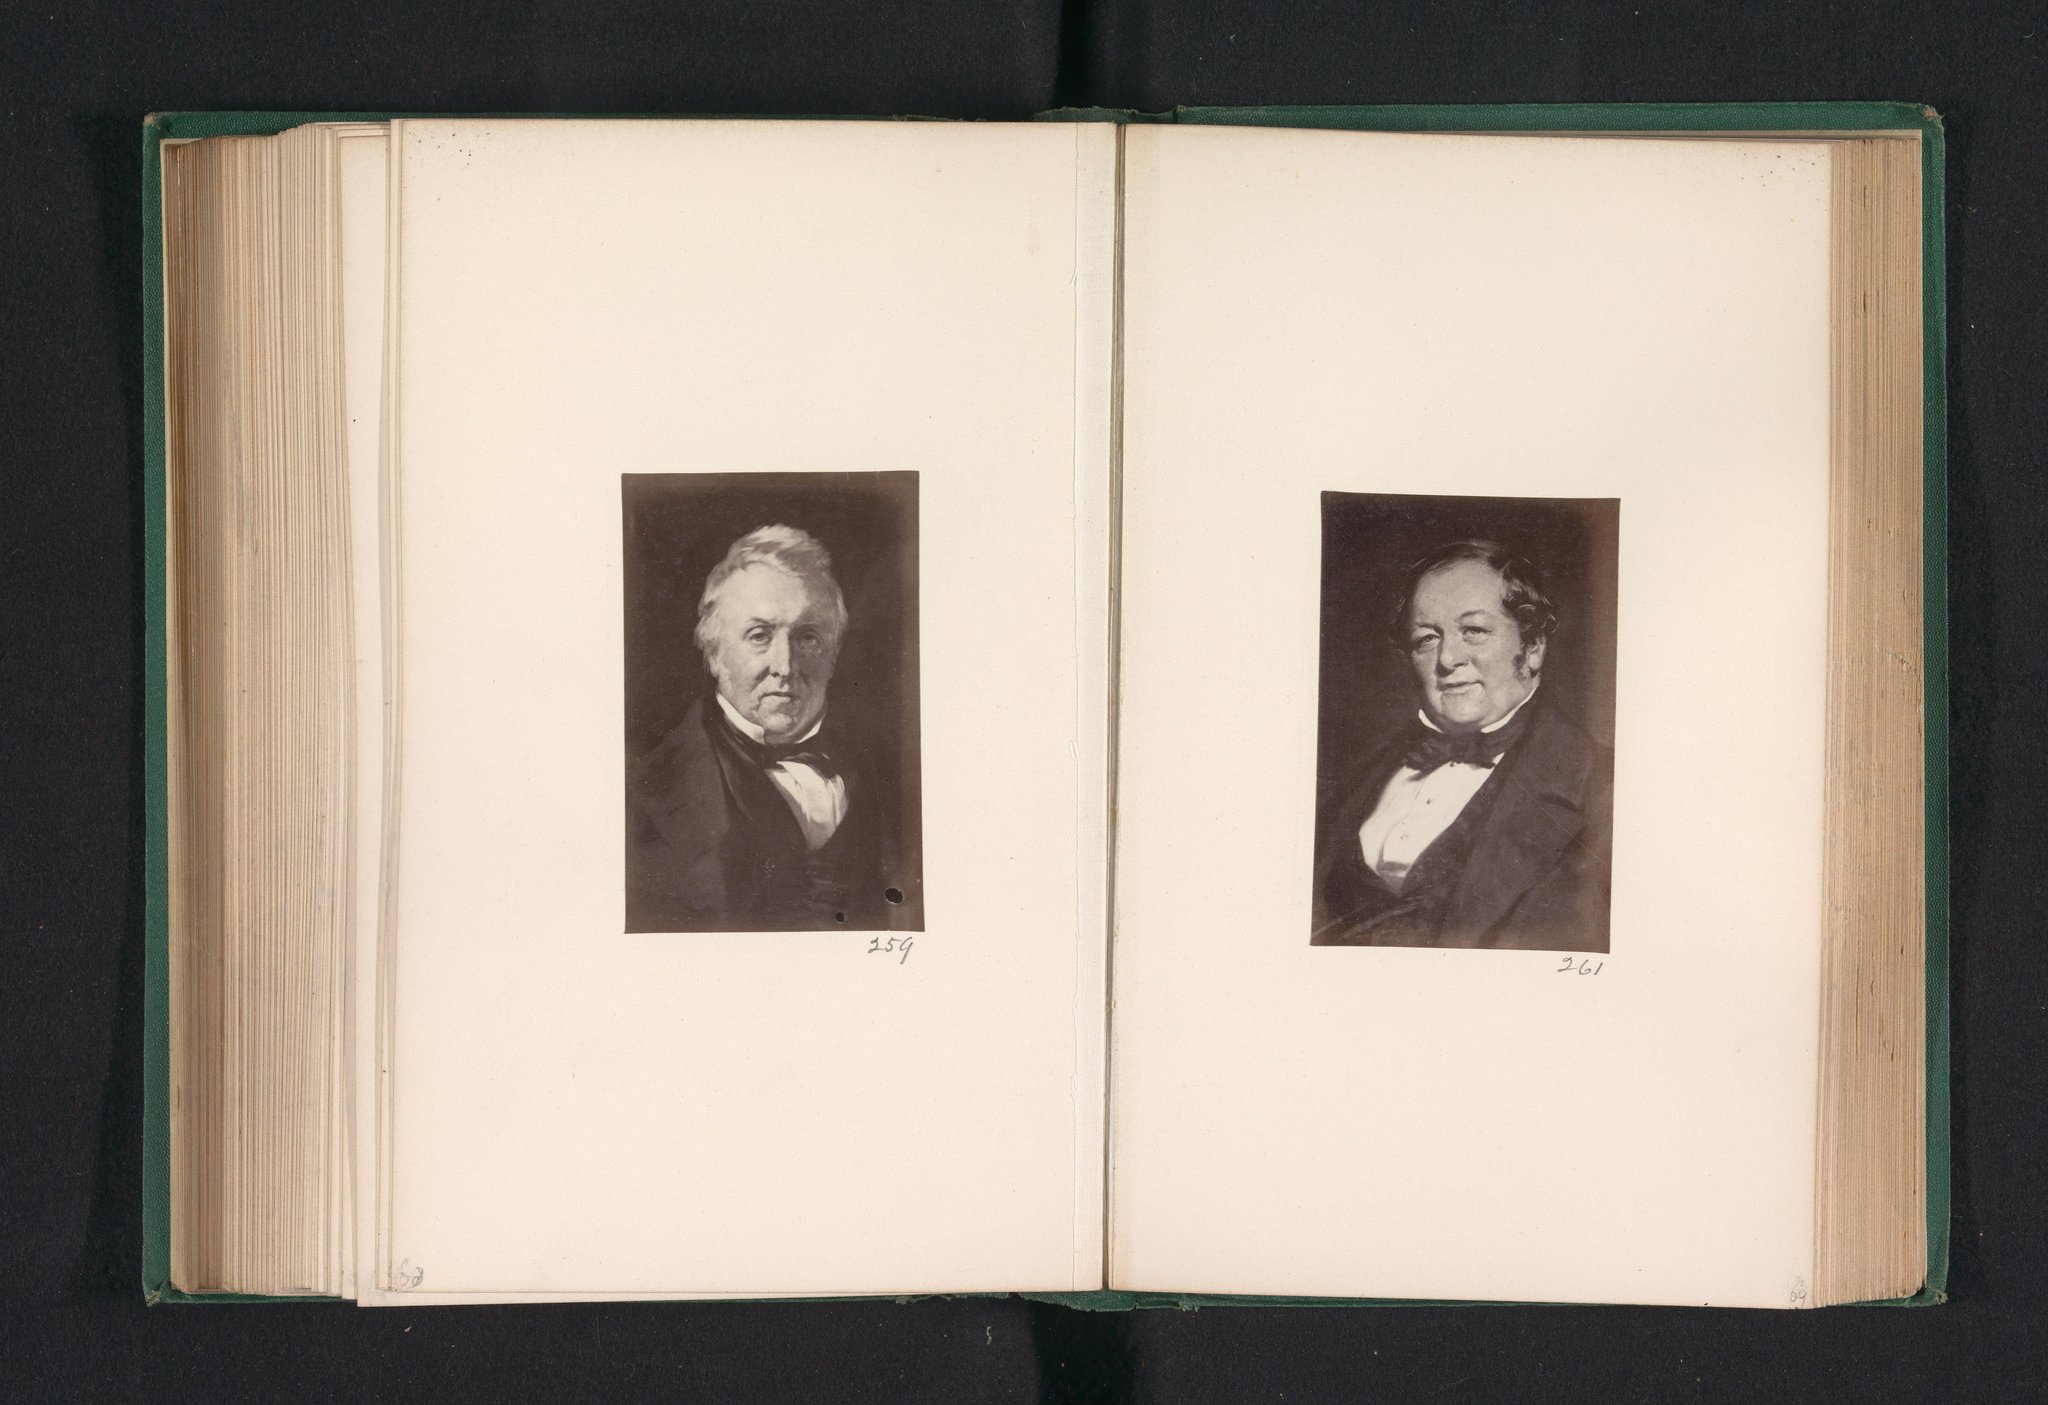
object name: photograph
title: Fotoreproductie van een schilderij, voorstellende een portret van John Aitchison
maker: thomas annan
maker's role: fotograaf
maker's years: 1829-1887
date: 1863-1868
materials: photographic support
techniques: albumen print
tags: historical persons (portraits and scenes from the life) (+ (full) bust portrait)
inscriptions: number: ‘259’